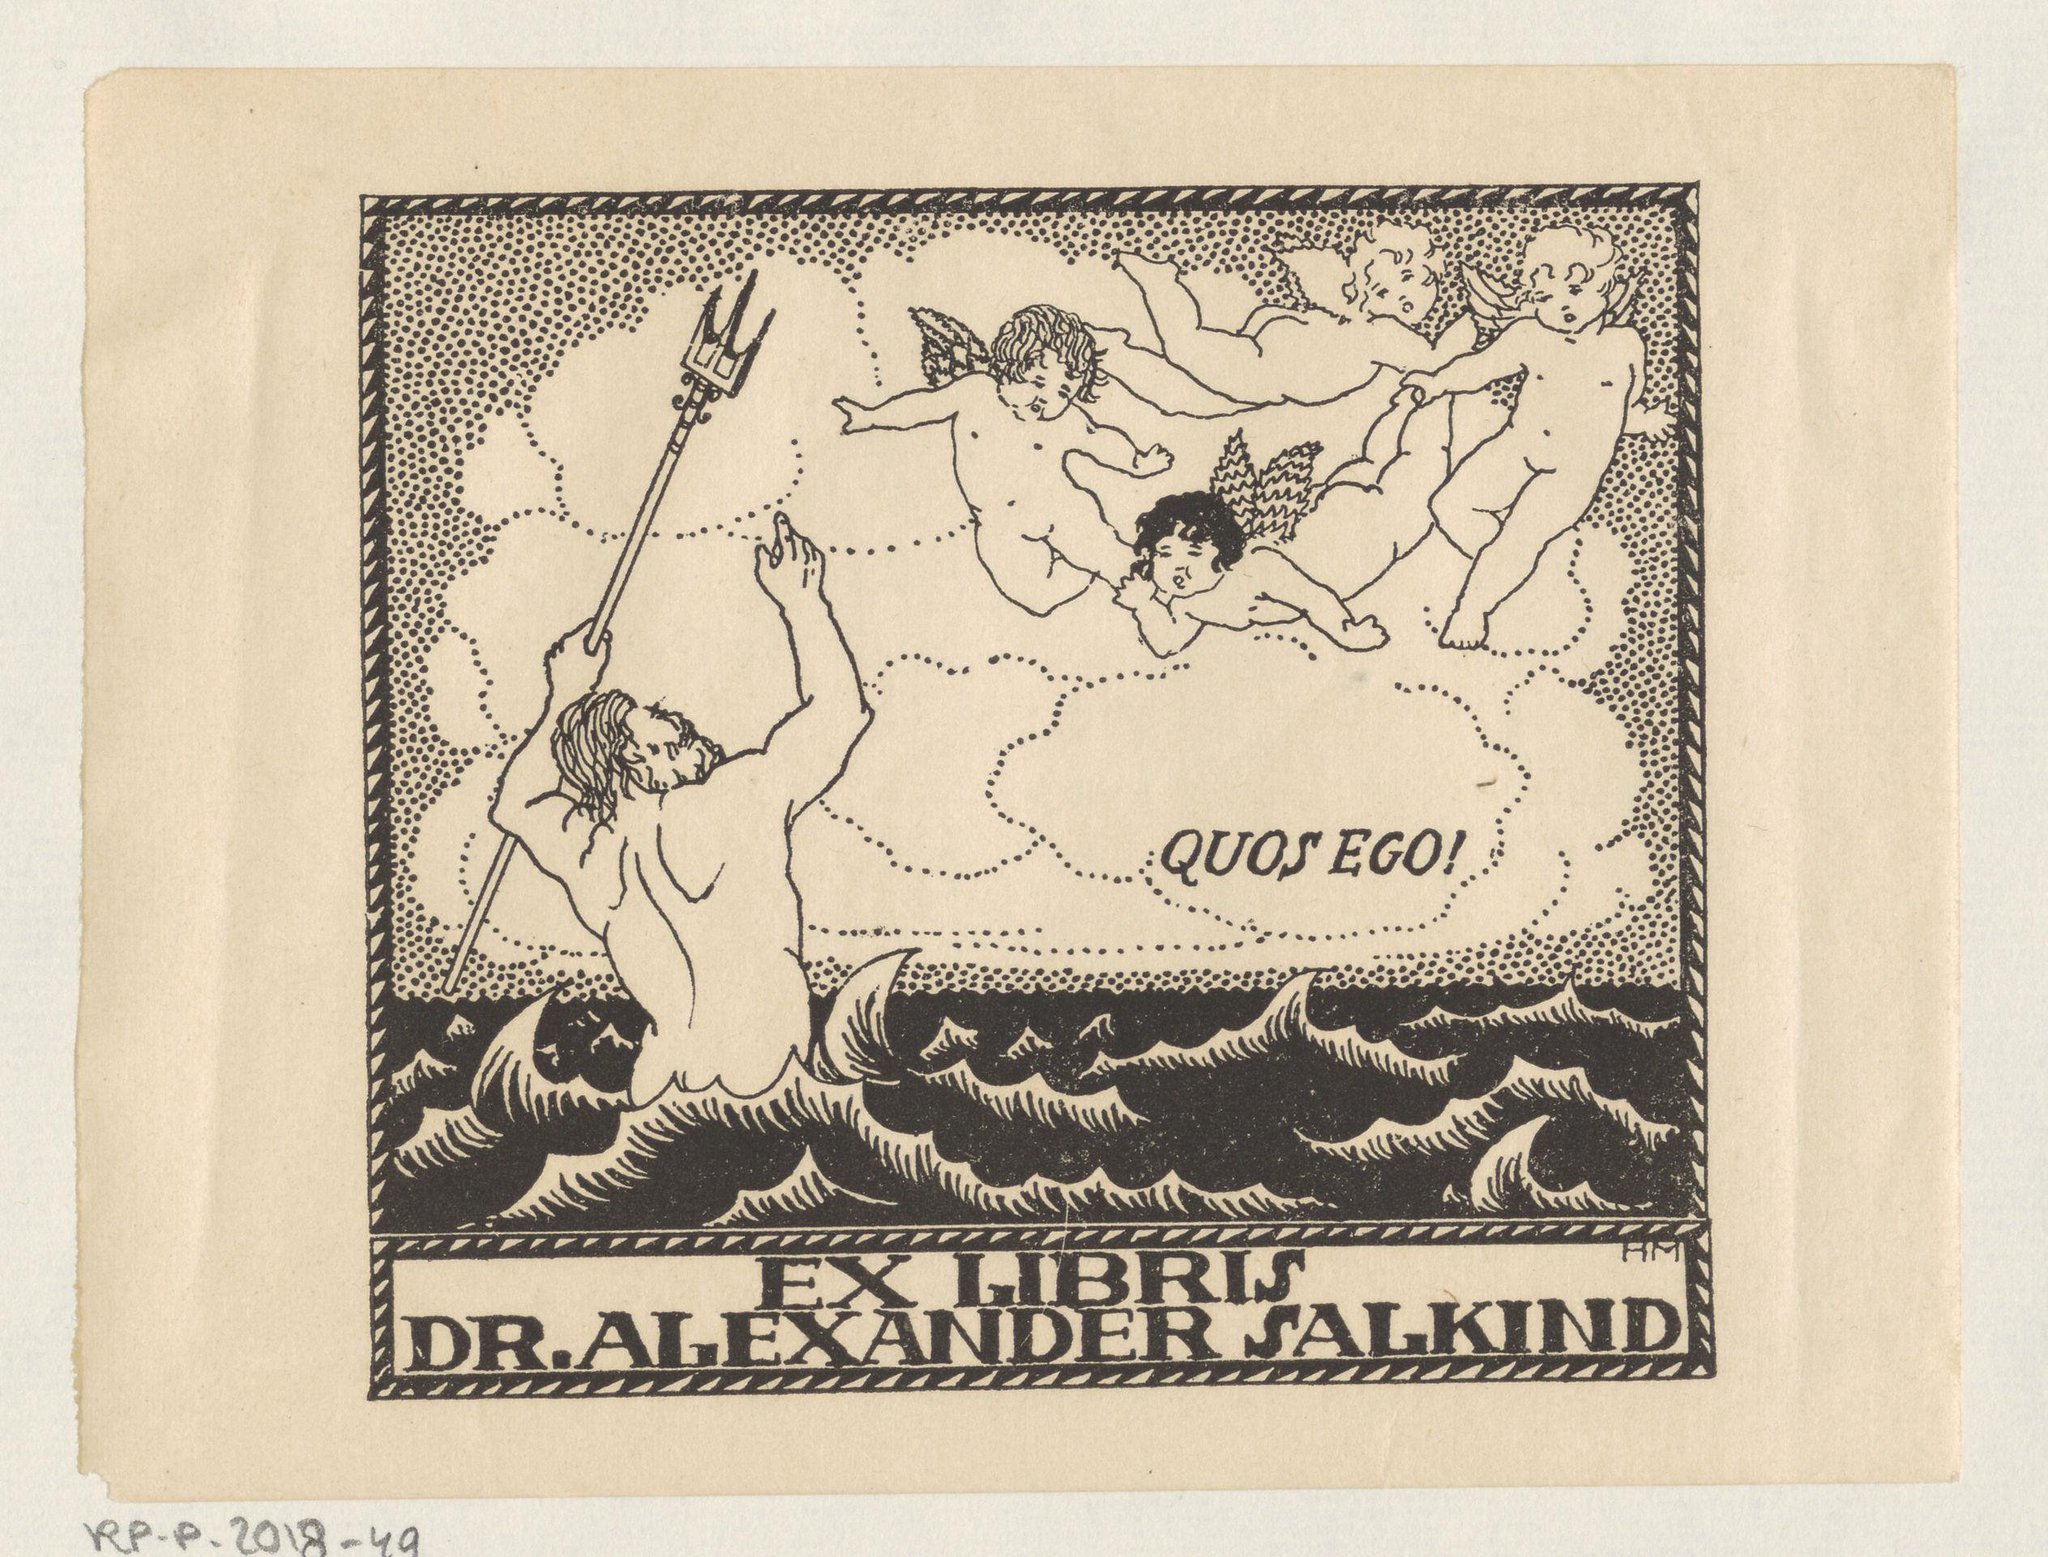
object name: bookplate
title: Quos ego!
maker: Anonymous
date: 1897-1940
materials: paper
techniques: lithograph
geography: germany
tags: (story of) neptune (poseidon), cupids: 'amores', 'amoretti', 'putti'